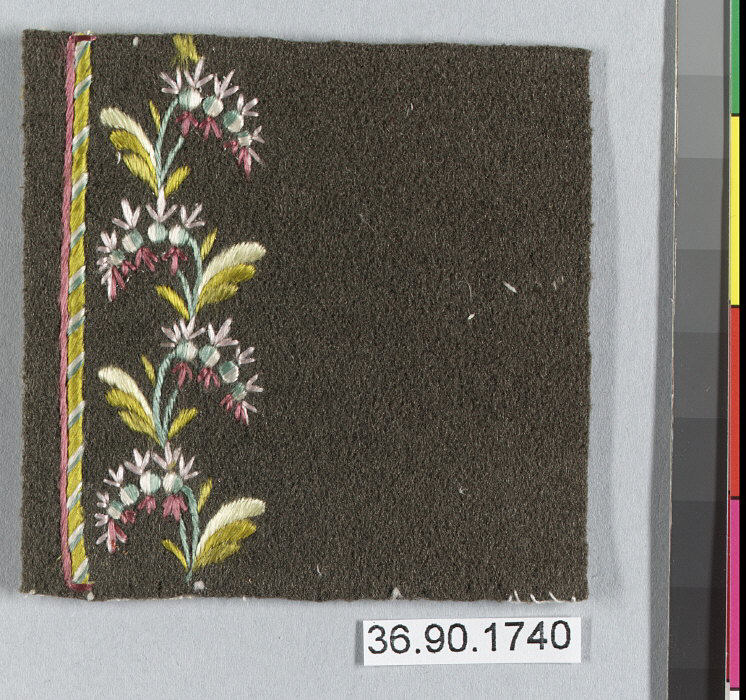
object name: sample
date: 1801-1833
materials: felt, silk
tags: plants